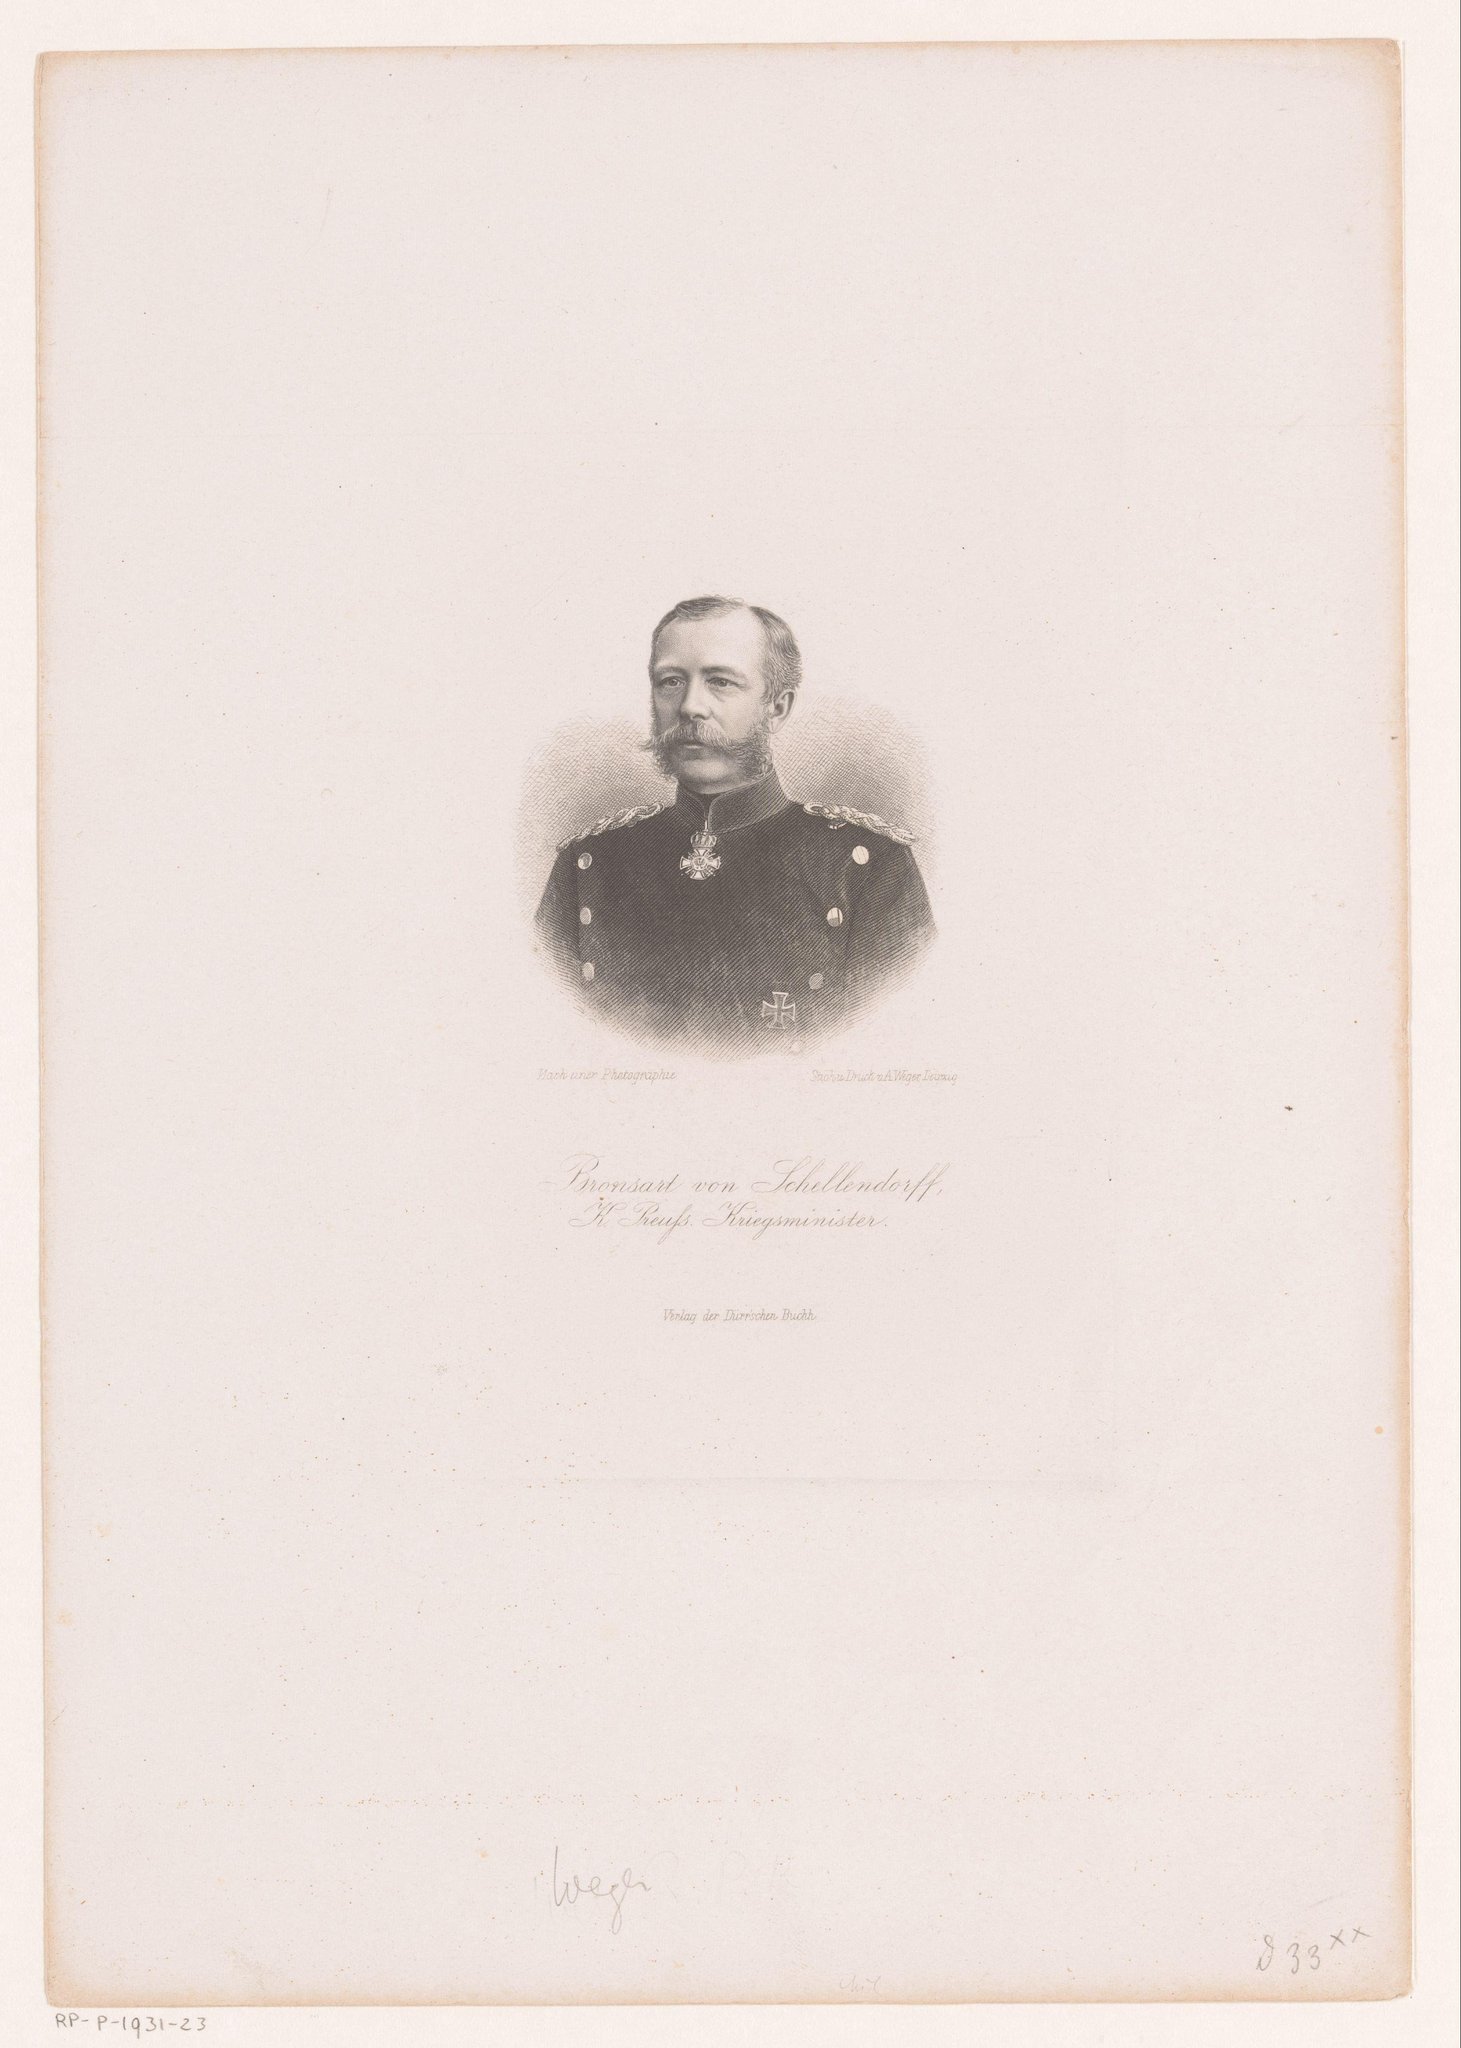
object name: print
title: Portret van Paul Bronsart von Schellendorff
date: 1883-1892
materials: paper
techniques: engraving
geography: leipzig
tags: historical persons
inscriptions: collector's mark: Lugt 2228